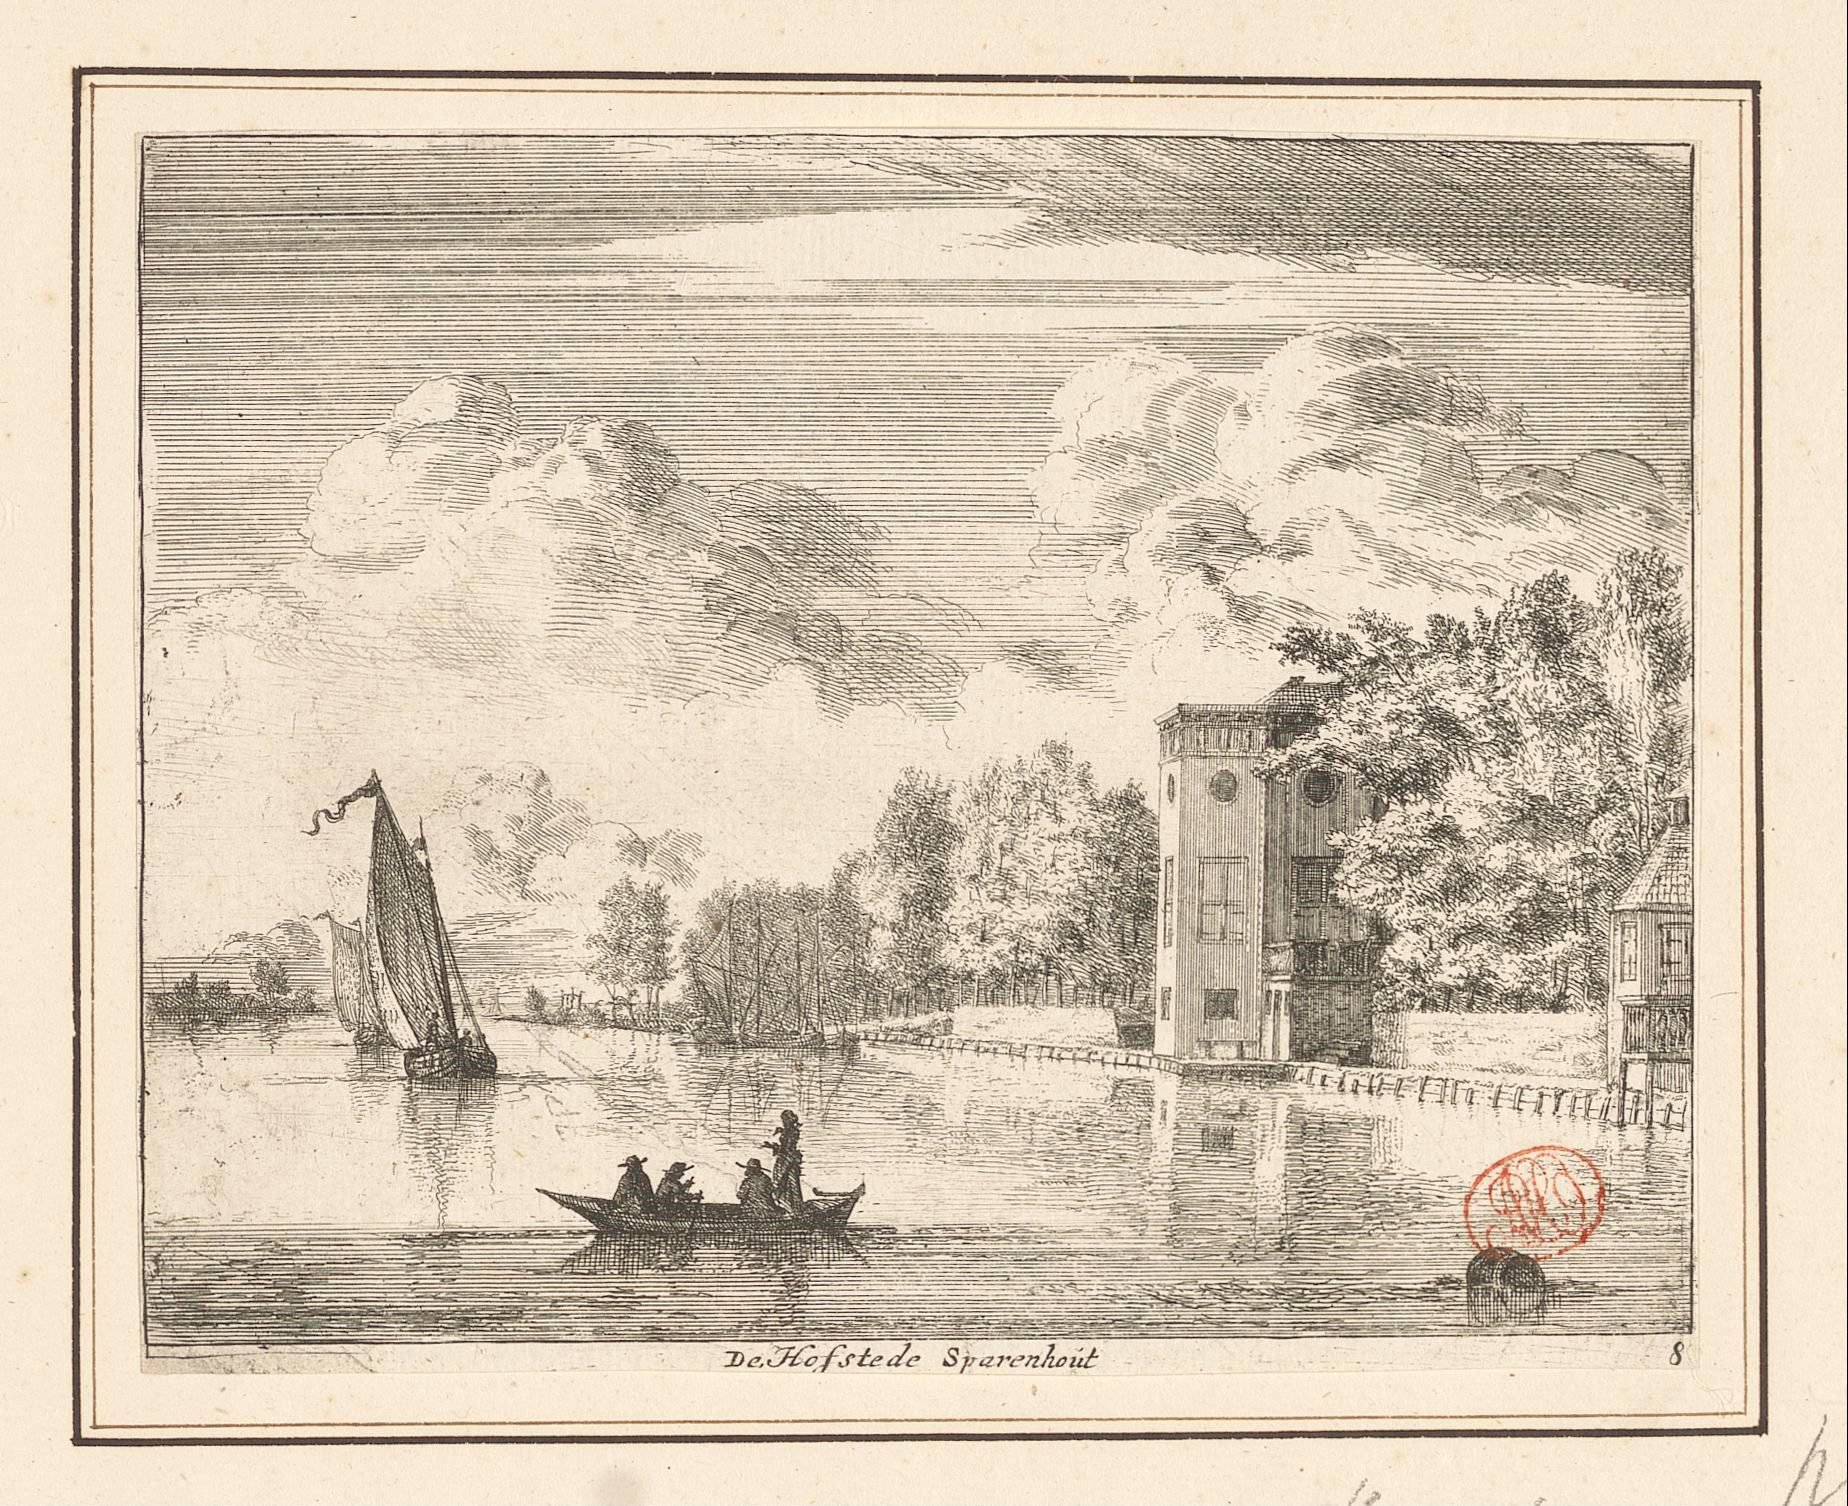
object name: print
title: De Hofstede Sparenhout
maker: jan vincentsz. van der vinne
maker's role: draughtsman, print maker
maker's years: 1663-1721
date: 1688-1690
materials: paper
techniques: etching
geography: haarlem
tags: sailing-ship, sailing-boat, landscapes (+ landscape with figures, staffage), outskirts of village (+ city(-scape) with figures, staffage)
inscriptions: collector's mark: Lugt 195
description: Gezicht op de hofstede Sparenhout te Haarlem. Op het water twee zeilschepen en een roeiboot met vier figuren. Rechtsonder genummerd: 8.